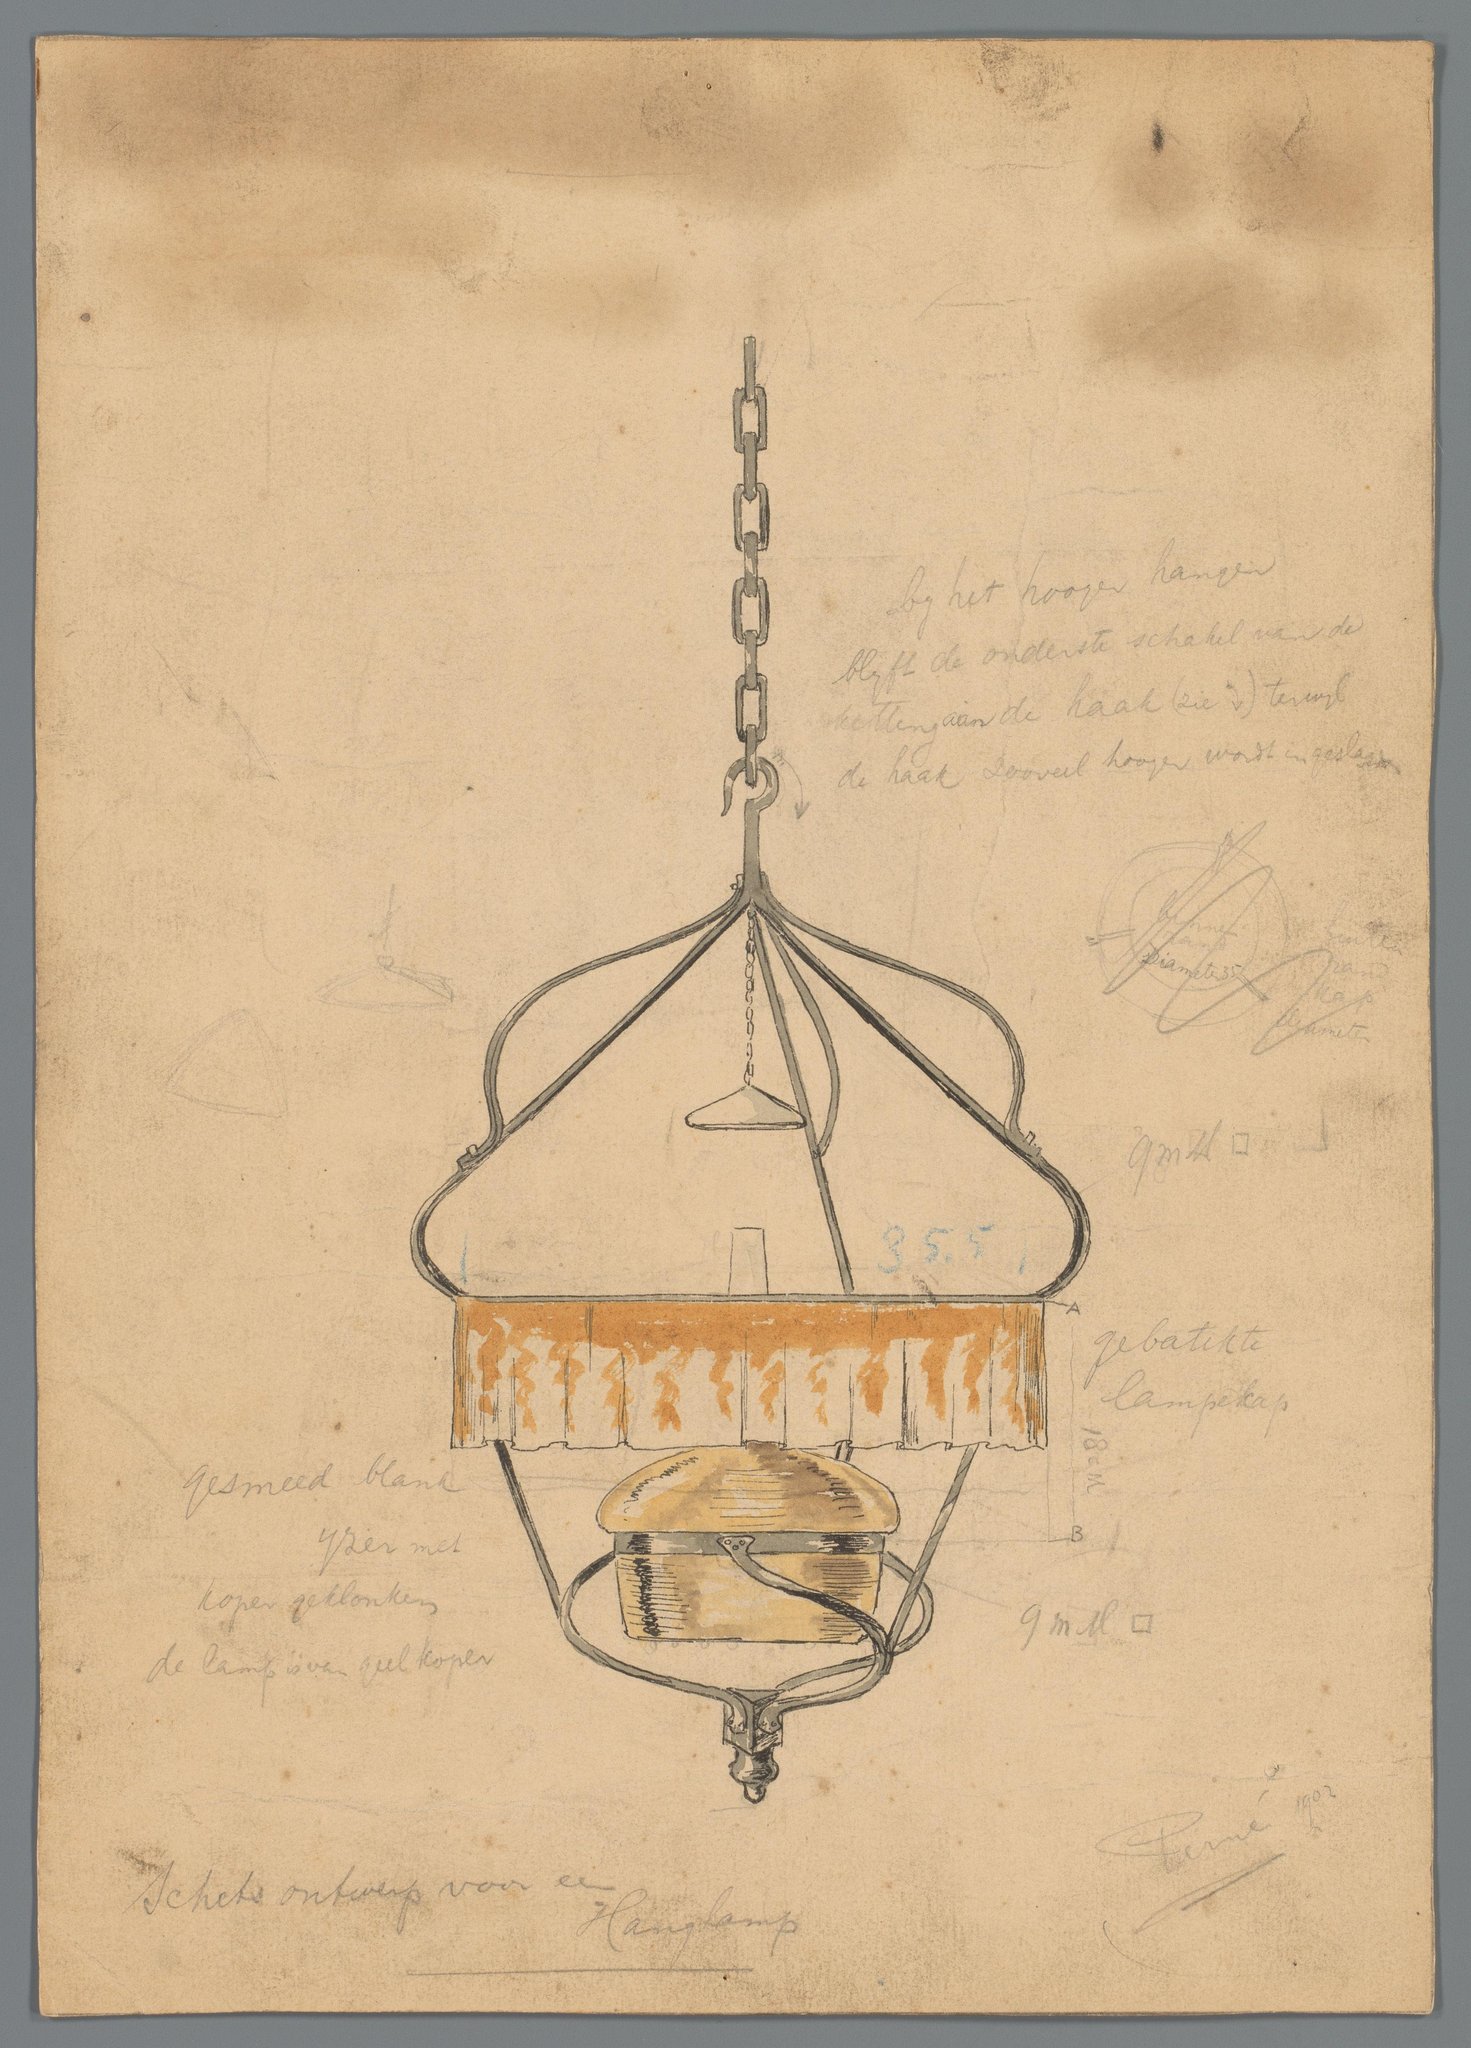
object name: design drawing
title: Ontwerp voor een hanglamp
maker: gust van de wall perné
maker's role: draughtsman, painter, print maker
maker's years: 1877-1911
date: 1902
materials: ink, paper, pencil, watercolor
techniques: brush, pen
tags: lighting; lamps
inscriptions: collector's mark: Lugt 2228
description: Met aantekeningen over de afmetingen en materialen van de lamp.